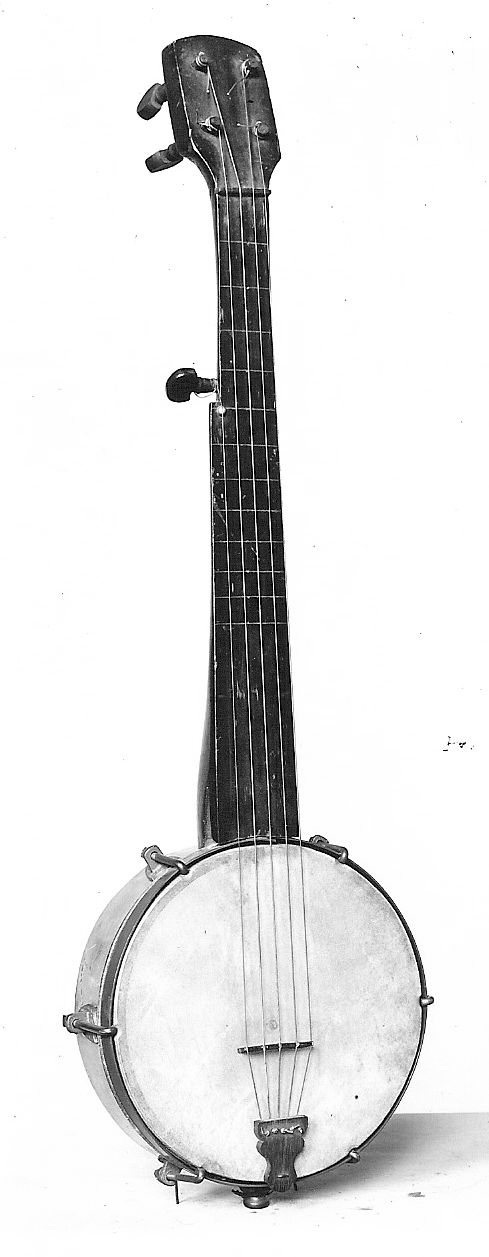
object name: piccolo banjo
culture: american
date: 1870-1880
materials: metal, parchment, wood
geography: united states